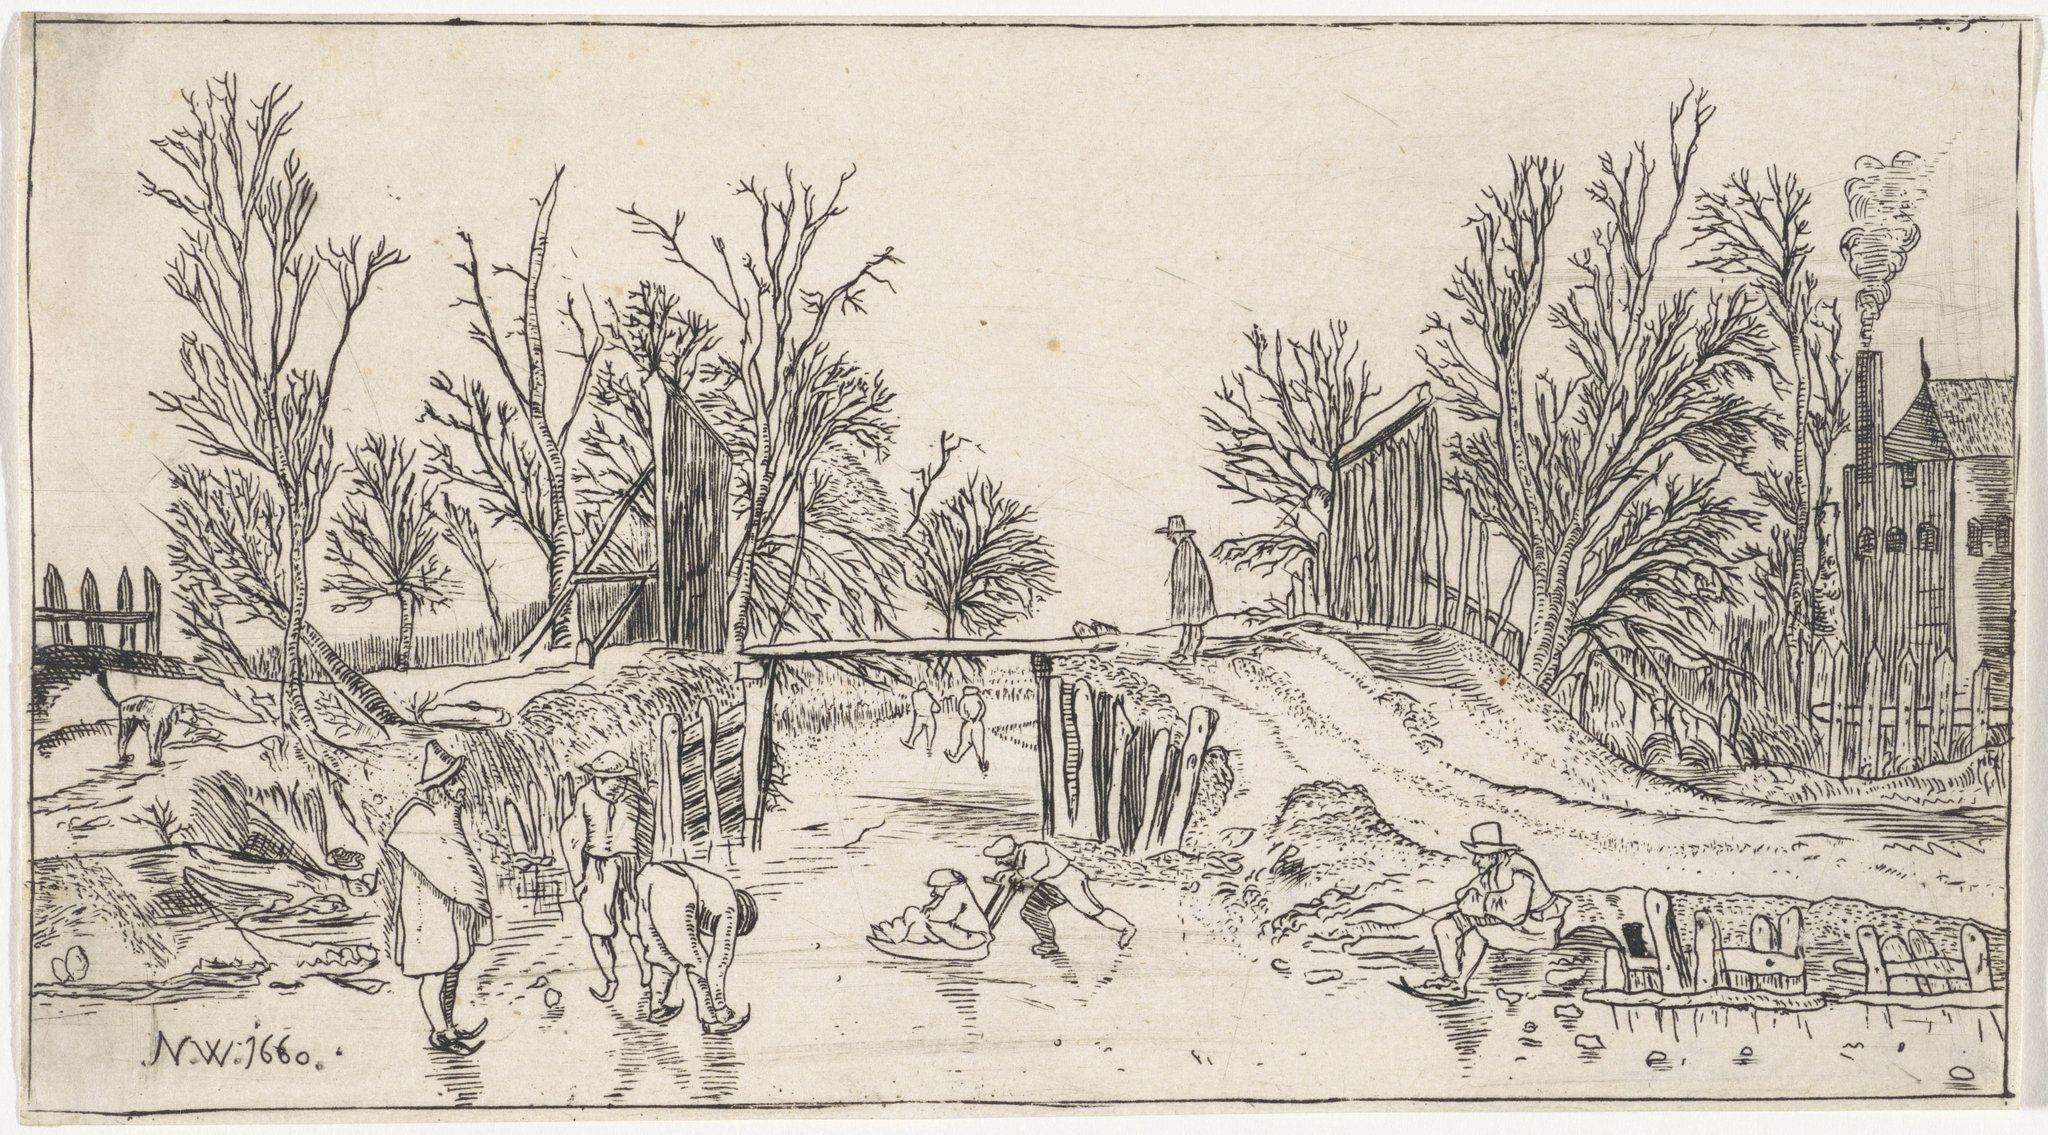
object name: print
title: Schaatsers bij een houten brug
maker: nicolaes cornelisz. witsen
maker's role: mayor, print maker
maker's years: 1641-1717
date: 1660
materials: paper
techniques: etching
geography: amsterdam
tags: skates (winter sports), sledge, sleigh (winter sports)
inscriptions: collector's mark: Lugt 2228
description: Winterlandschap met schaatsers en sleeënde mensen op een bevroren rivier. Bij een houten brug over de rivier staat een wandelaar. Rechts een gebouw met een rokende schoorsteen.